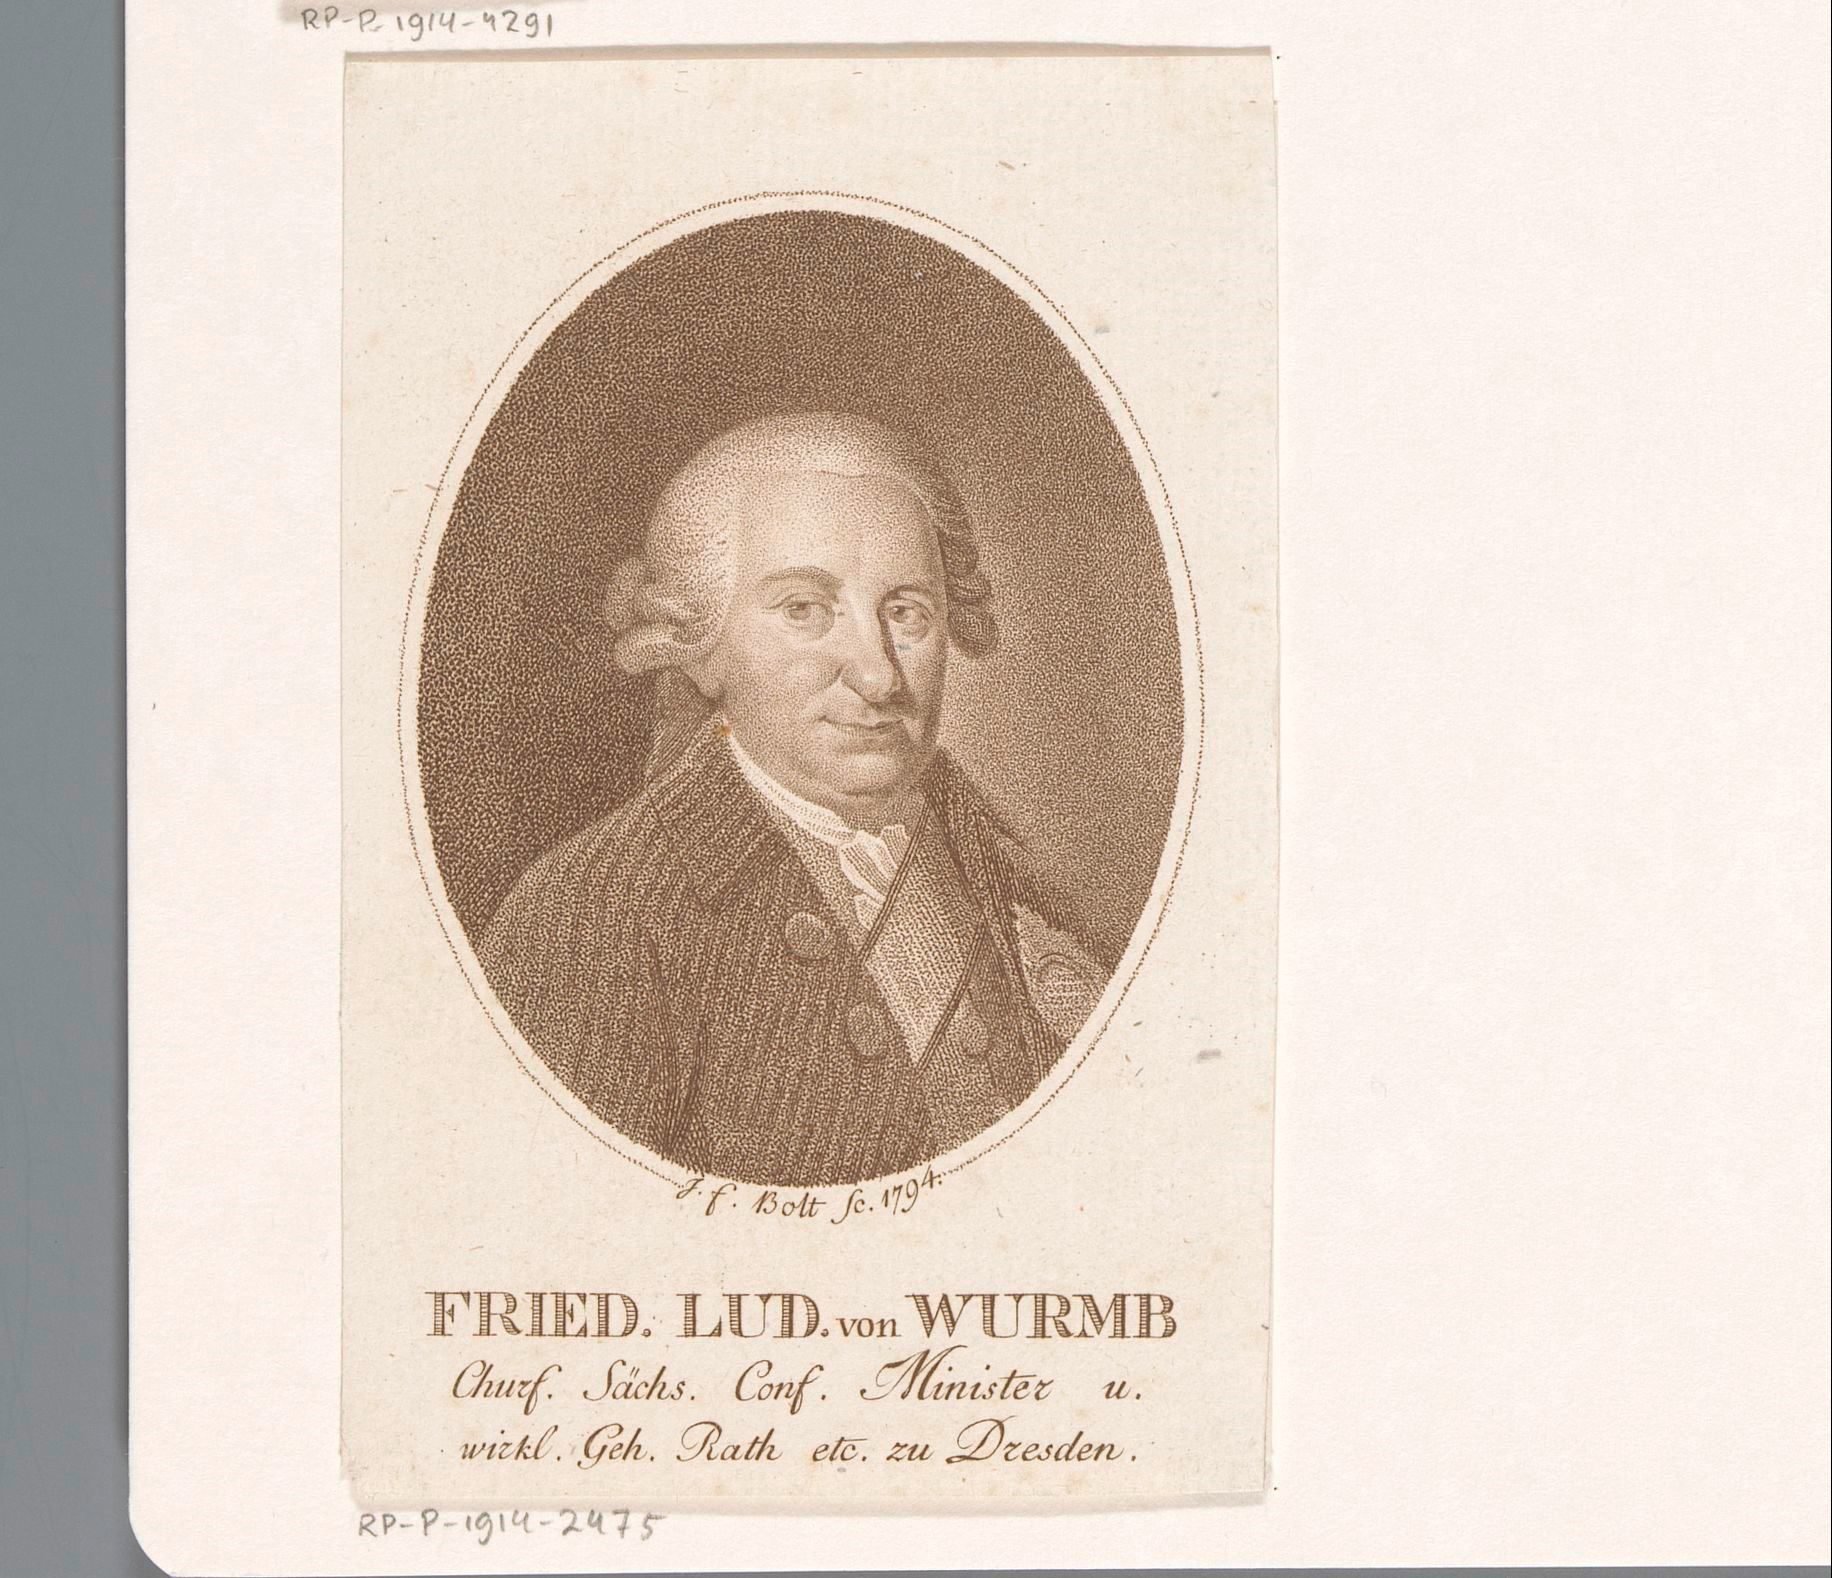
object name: print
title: Portret van Friedrich Ludwig von Wurmb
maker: johann friedrich bolt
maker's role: print maker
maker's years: 1769-1836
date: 1794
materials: paper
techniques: stippling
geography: berlin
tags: knighthood order, historical persons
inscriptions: collector's mark: Lugt 2228